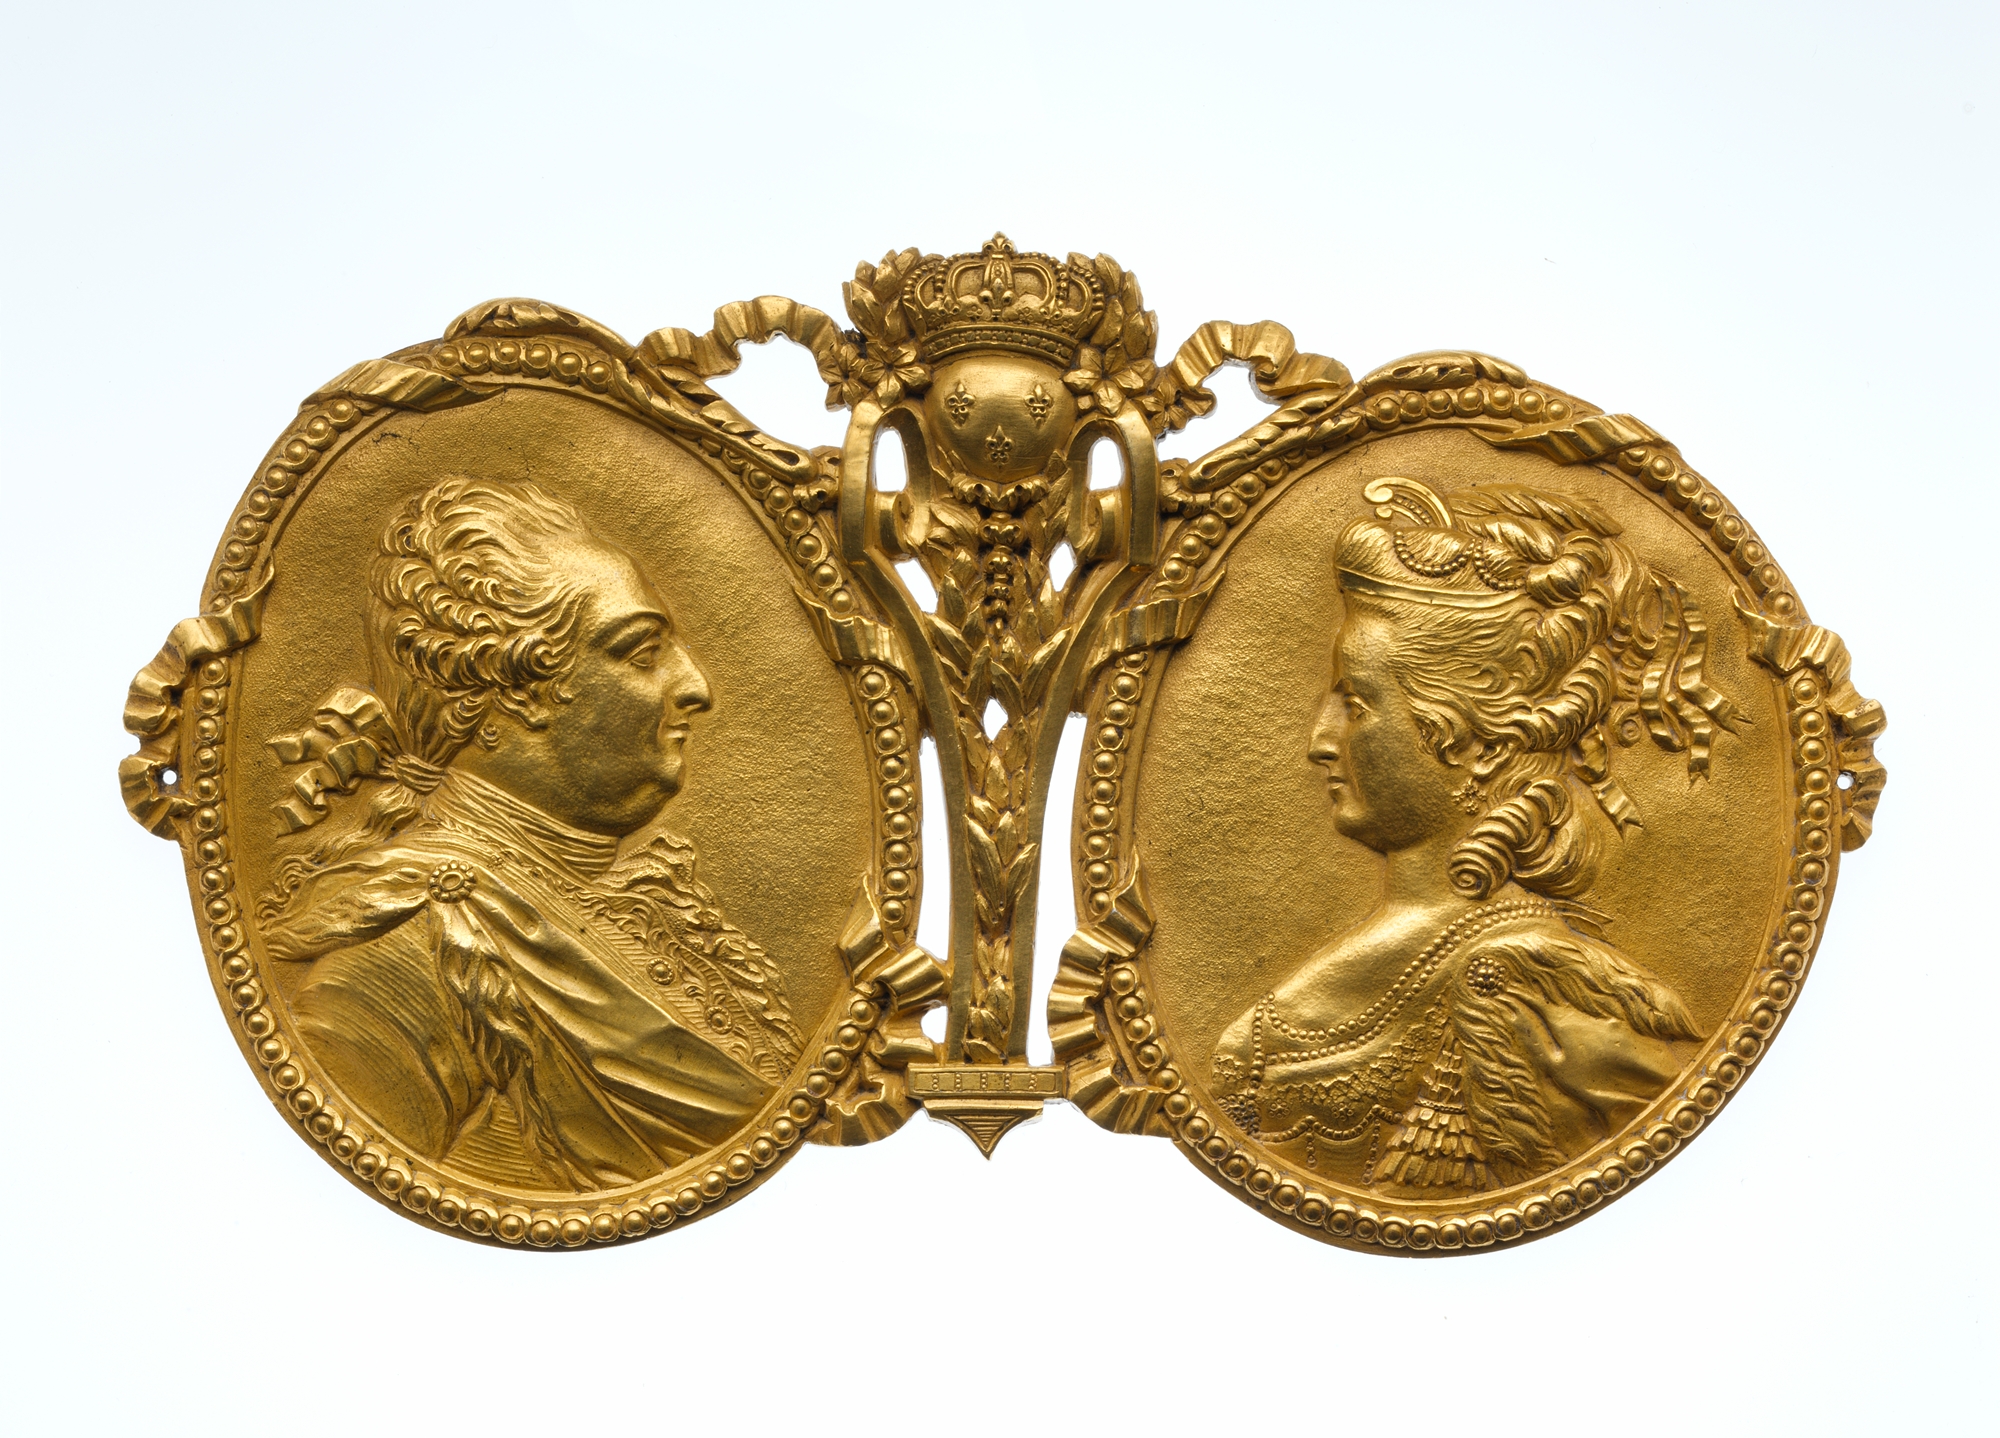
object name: portrait medallion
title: Portrait medallions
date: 1782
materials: gilt bronze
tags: men,profiles,women